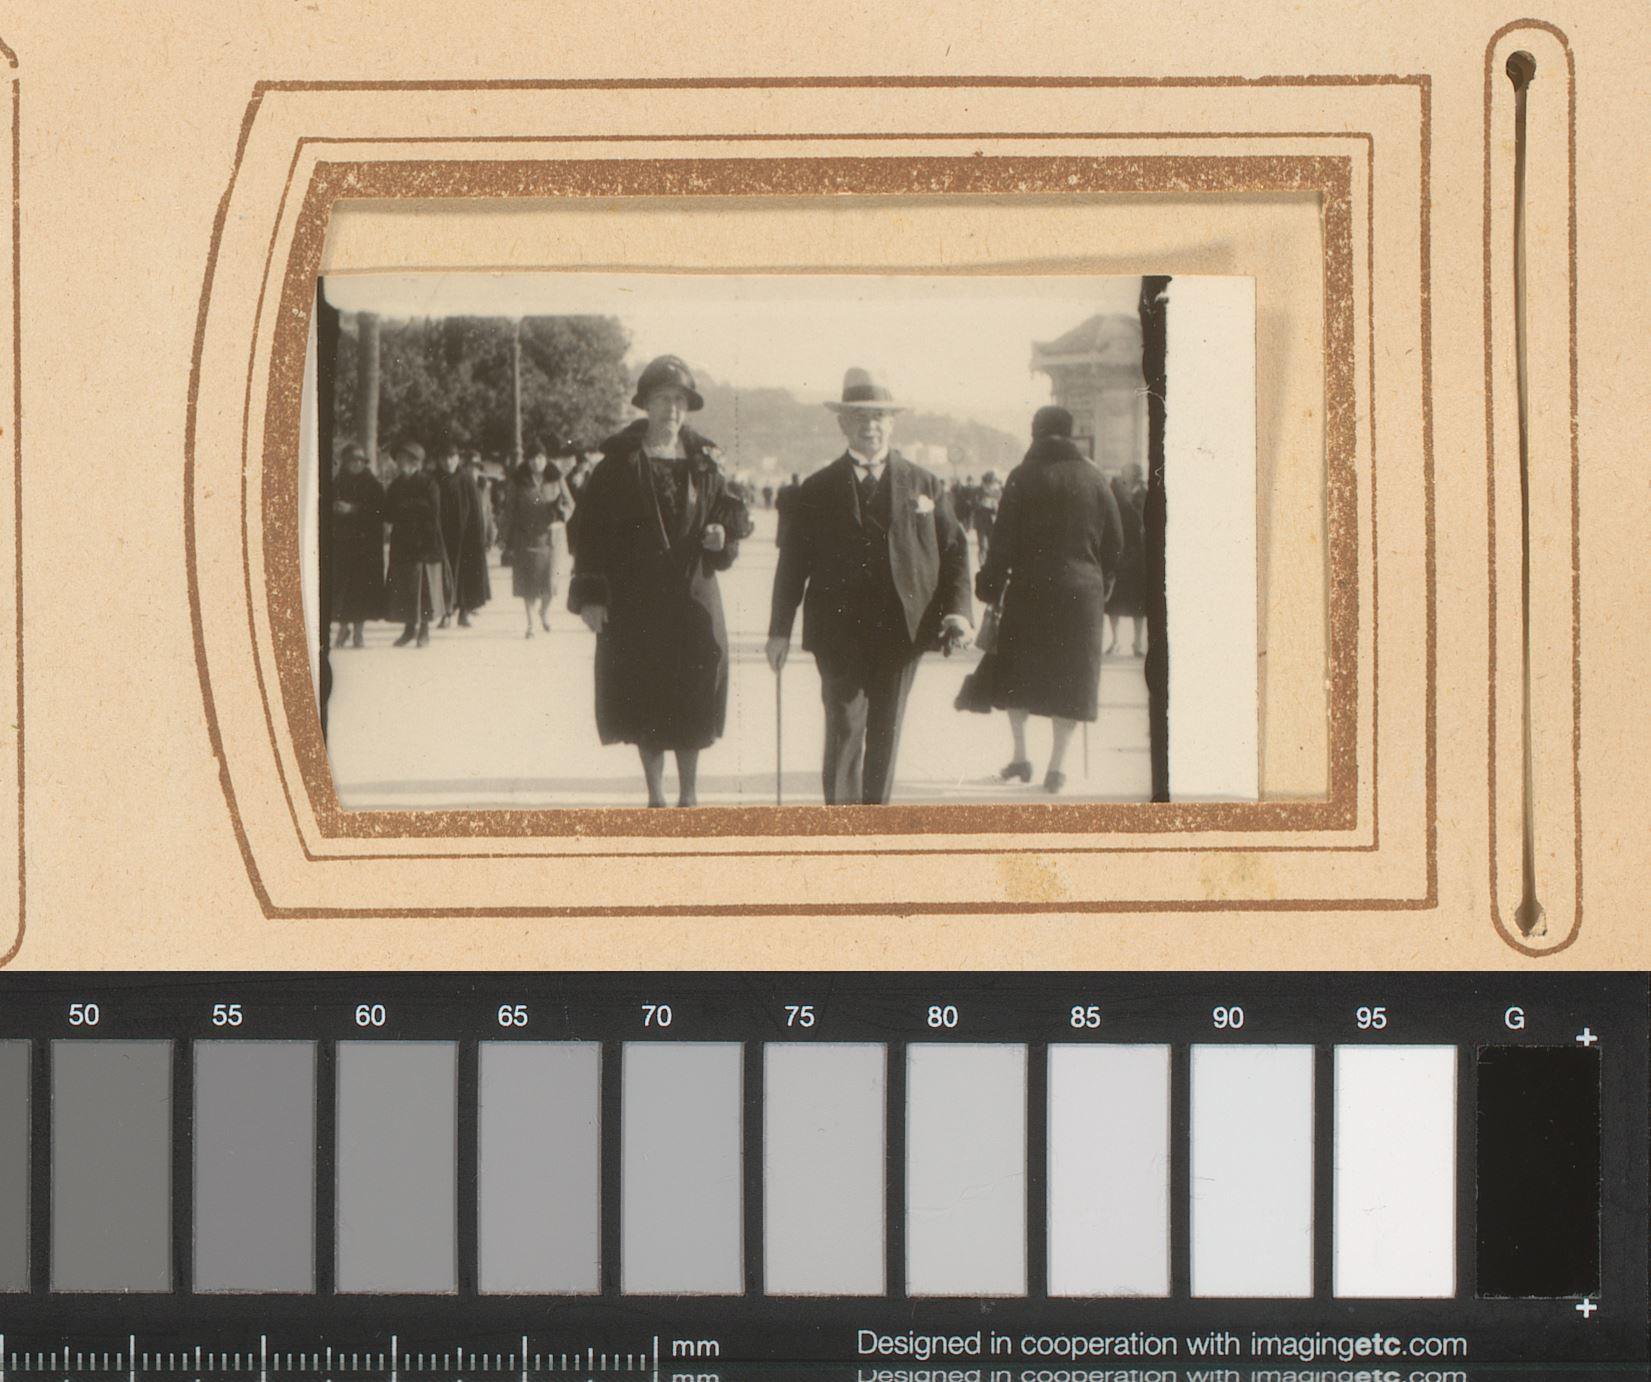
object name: album leaf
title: Straatgezicht met lopend echtpaar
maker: Anonymous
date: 1910-1950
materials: photographic support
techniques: gelatin silver print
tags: couple of lovers, street (+ city(-scape) with figures, staffage)